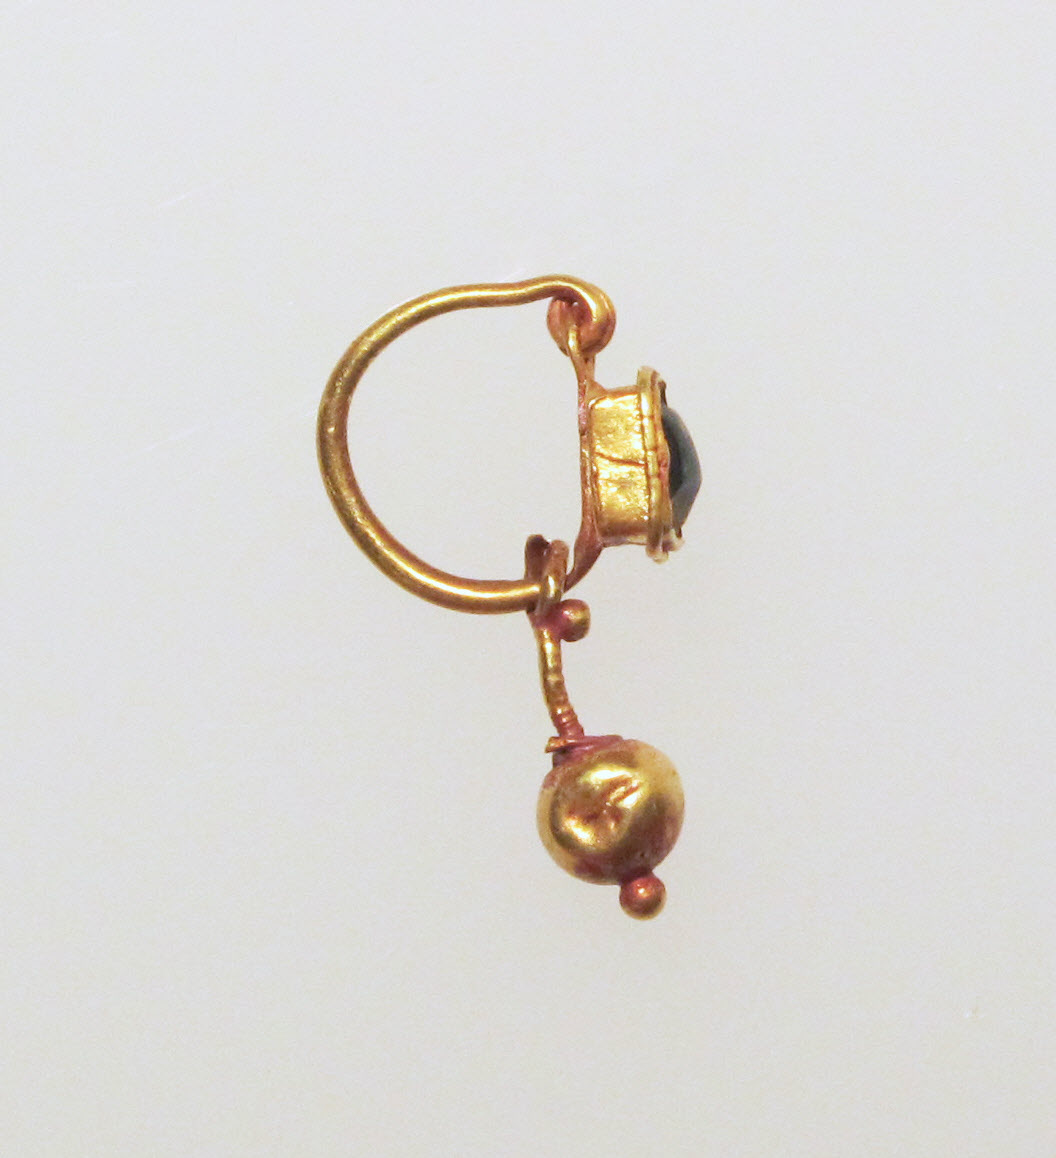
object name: earring with ball pendant and green stone setting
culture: roman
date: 670 BCE-330 CE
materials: gold